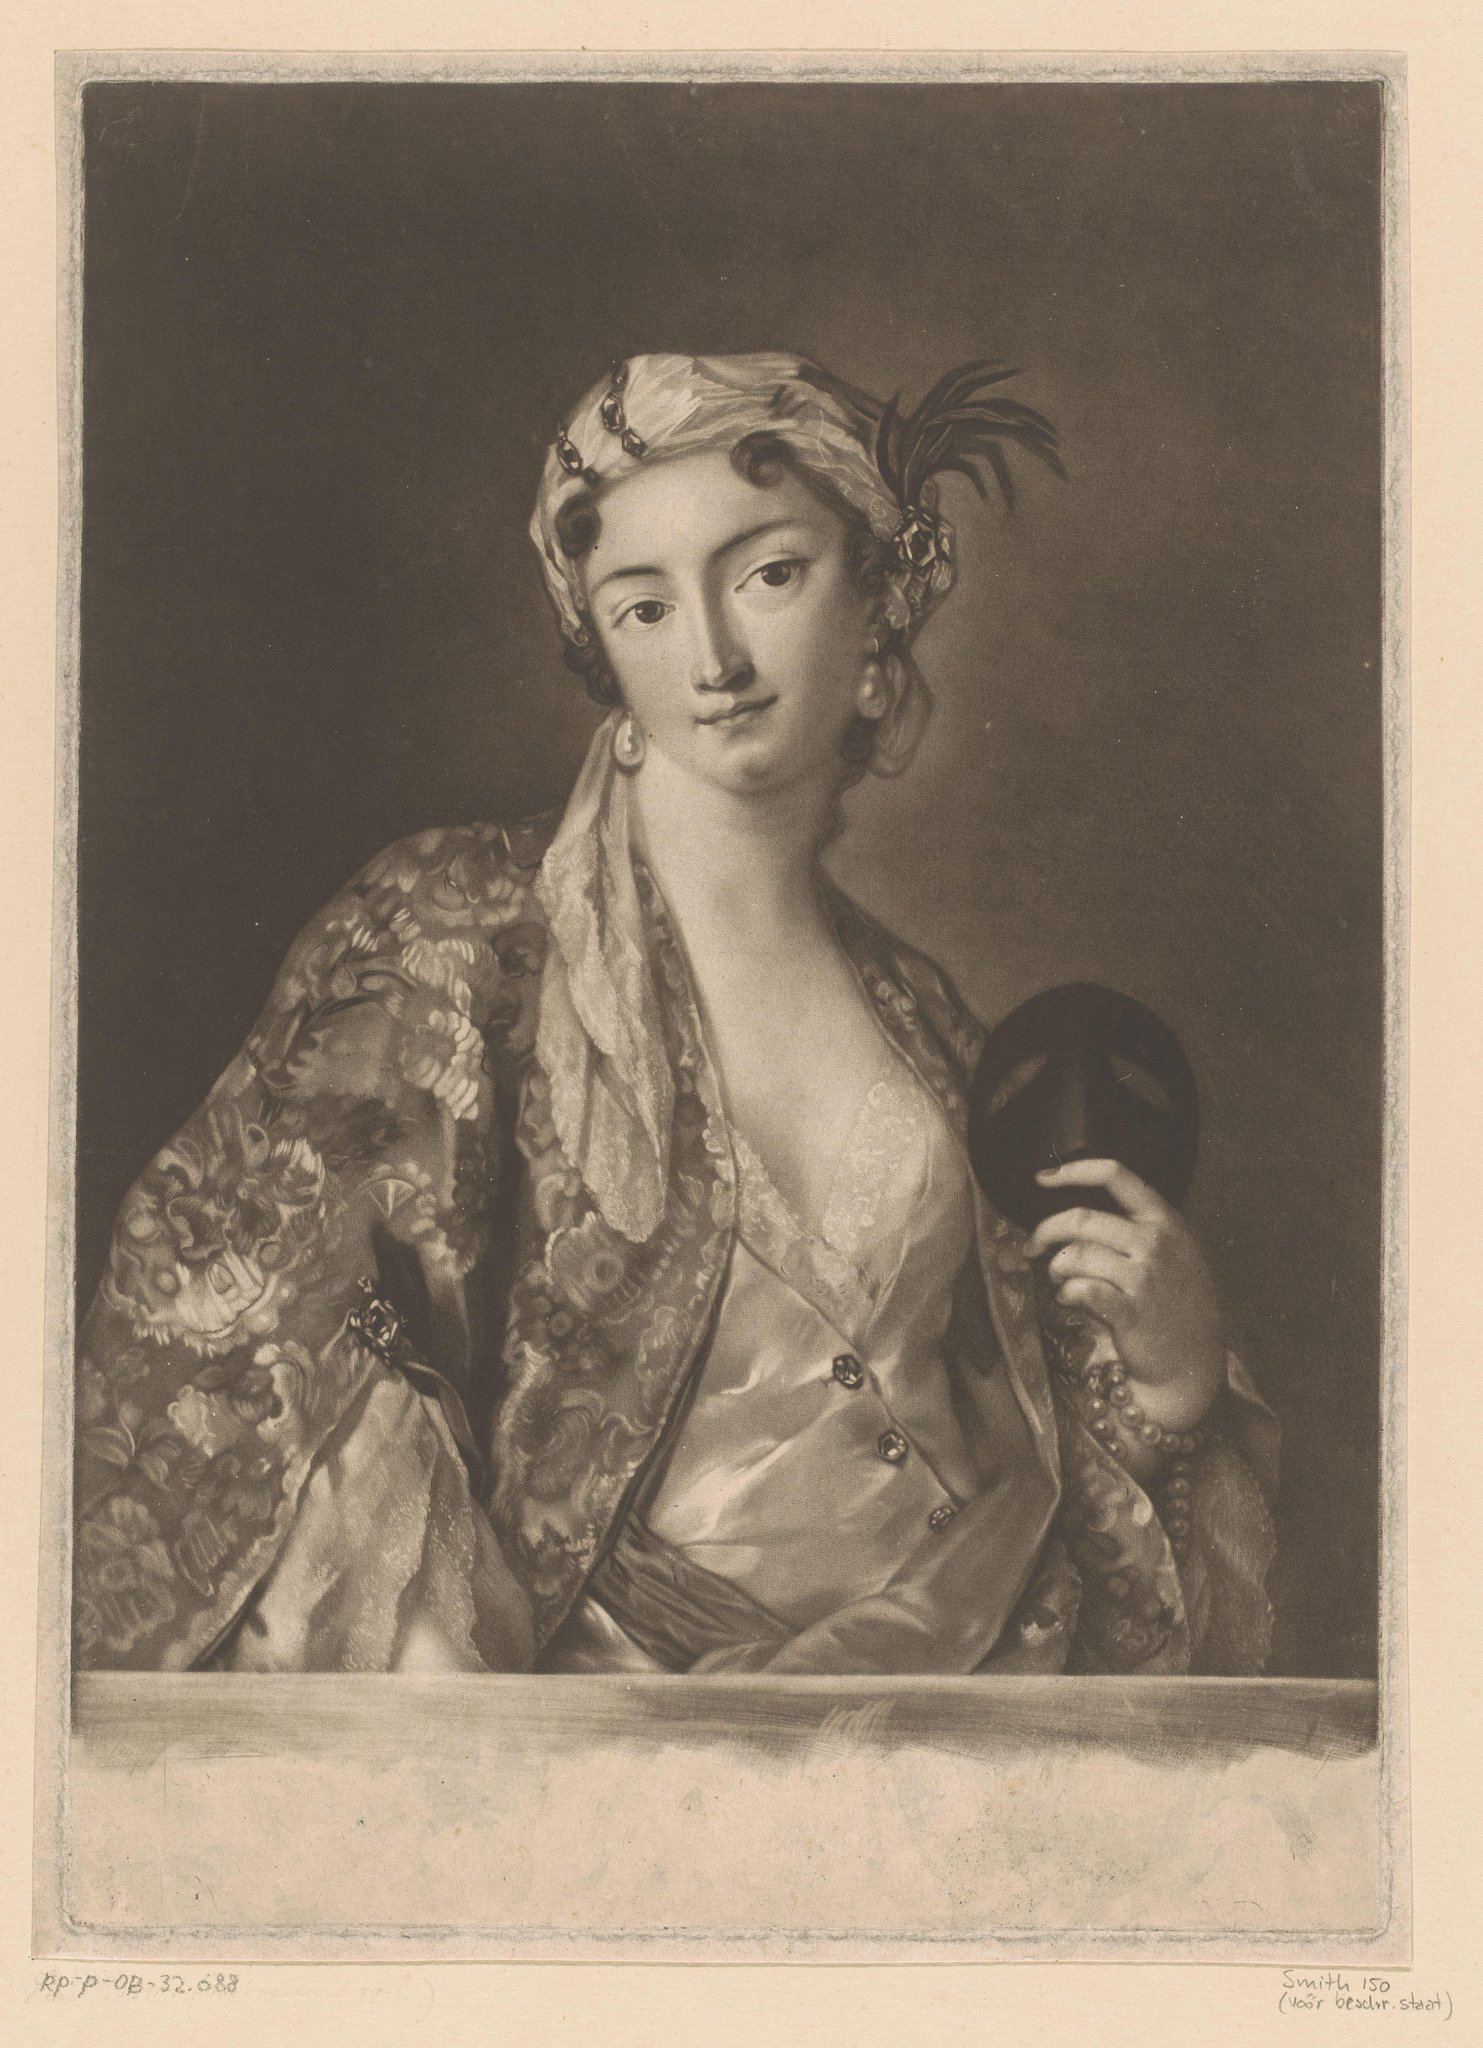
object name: print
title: Vrouw met een hoofddoek en parel oorbellen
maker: richard houston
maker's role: print maker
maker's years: 1721-1775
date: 1731-1775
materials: paper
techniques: mezzotint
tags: adolescent, young woman, maiden, masquerade, masked ball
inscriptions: collector's mark: Lugt 240